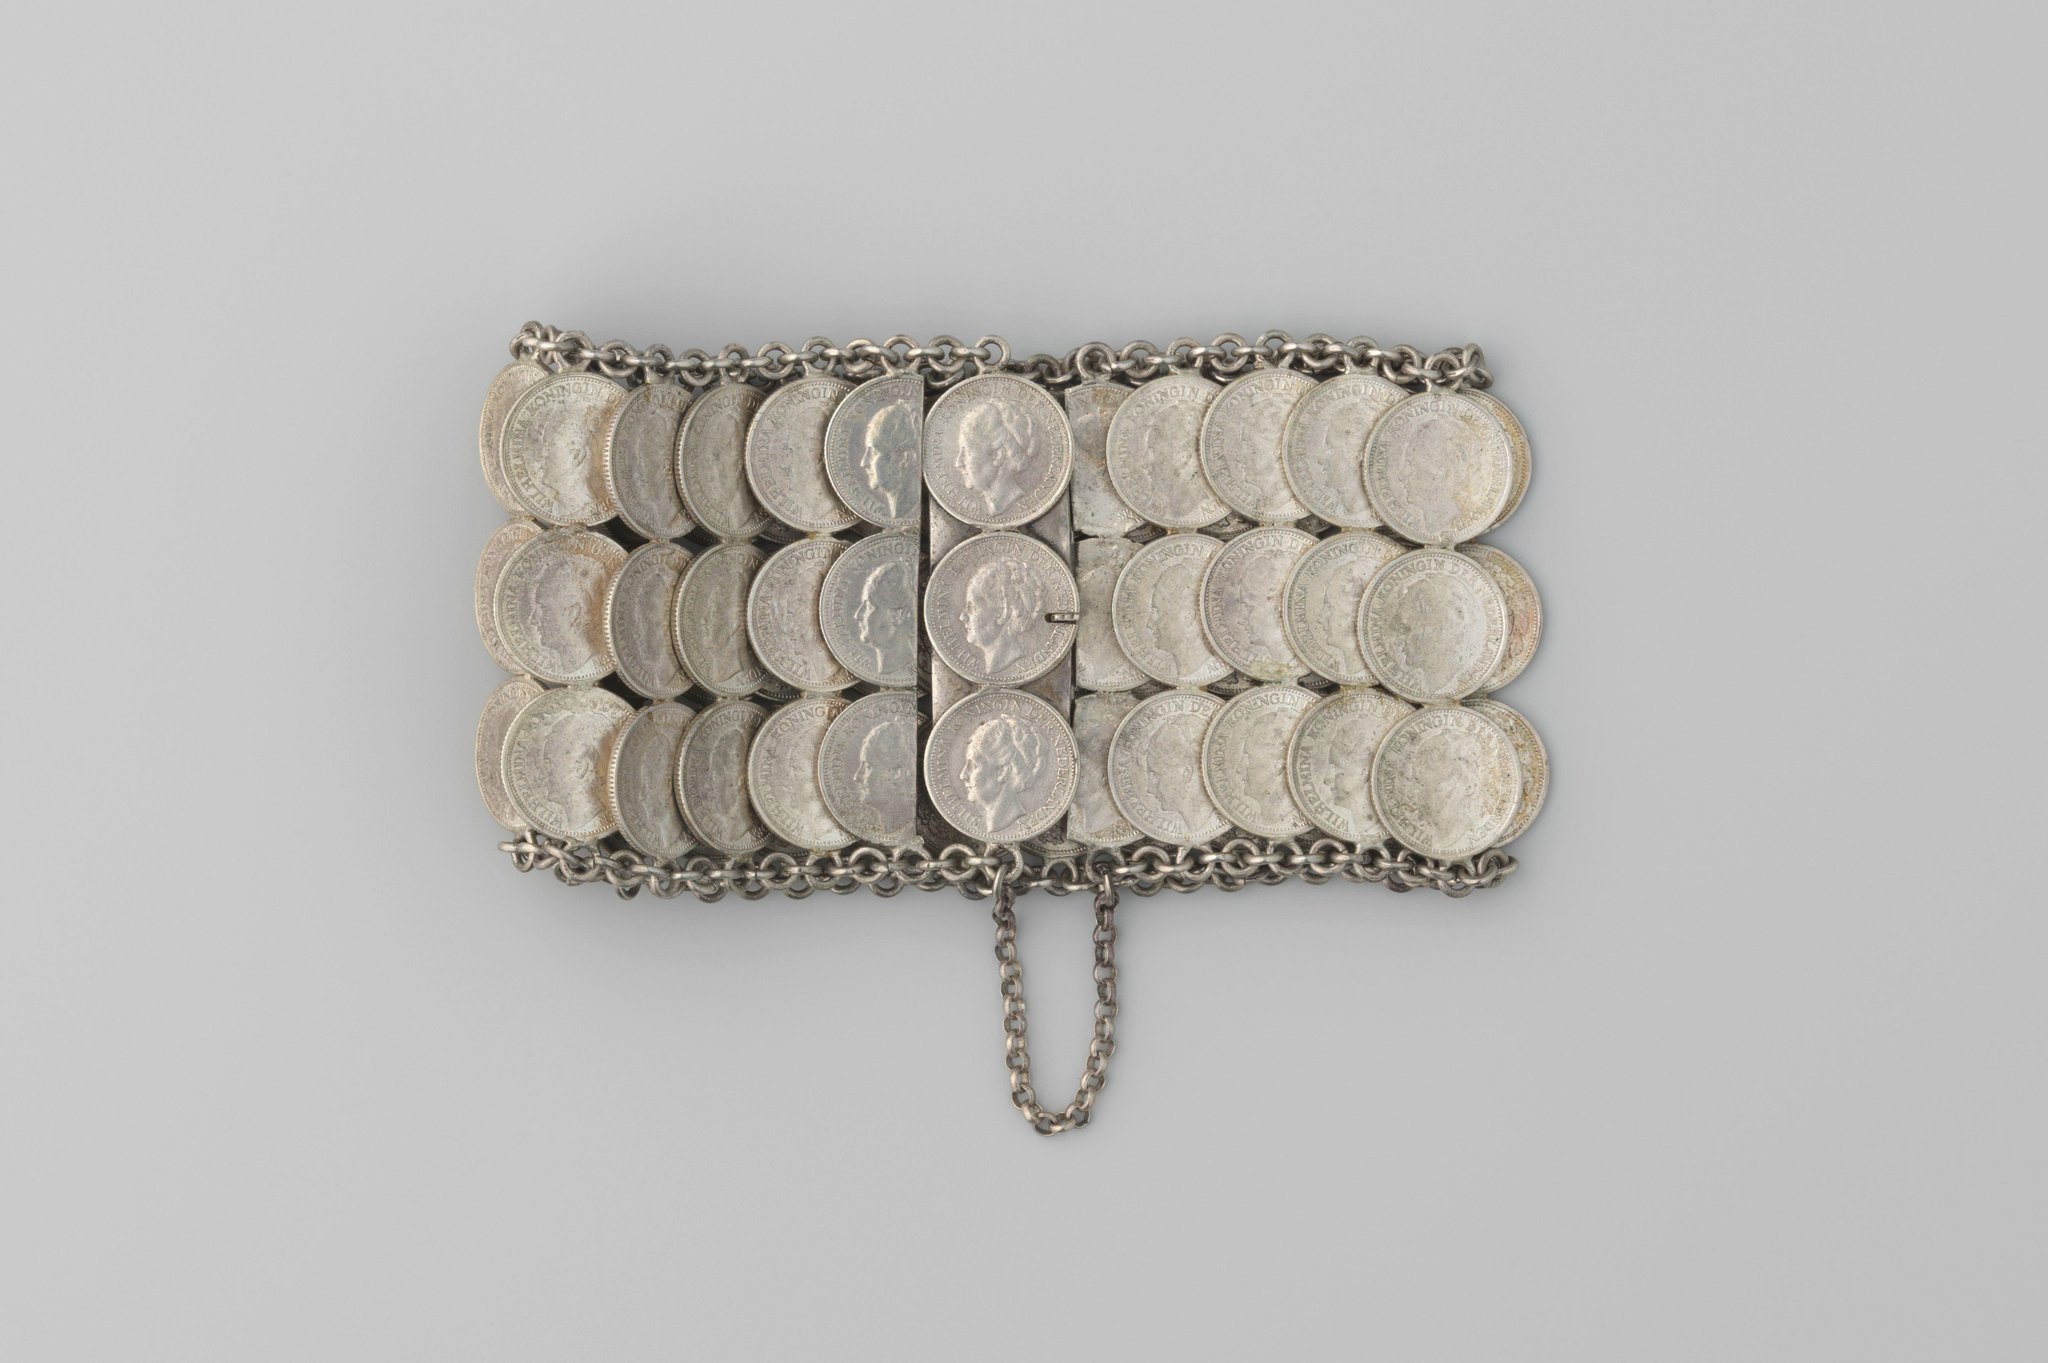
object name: bracelet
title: Miscellaneous coin jewellery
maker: Anonymous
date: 1940-1950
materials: silver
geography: netherlands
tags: print maker, wilhelmina of the netherlands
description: Silent Resistance –War and Liberation Jewellery During the Second World War, small pieces of jewellery were worn in the Netherlands as a silent protest against the German occupier. In April 1941, Dutch coins were officially confiscated for the war industry. As jewellery did not have to be surrendered, coins were quickly transformed into rings, brooches, pins and bracelets. A portrait of Queen Wilhelmina was worn as a sign of resistance, as well as a token of loyalty to the royal family. Margriet Francisca, the third daughter of Princess Juliana and Prince Bernard, was born in Canada in January 1943. The pin with the three yellow chicks refers to the three young princesses Beatrix, Irene and Margriet and the steadfastness of the Dutch royal family. After the liberation, coins and silver were used for jewellery conveying messages of hope for a peaceful future.